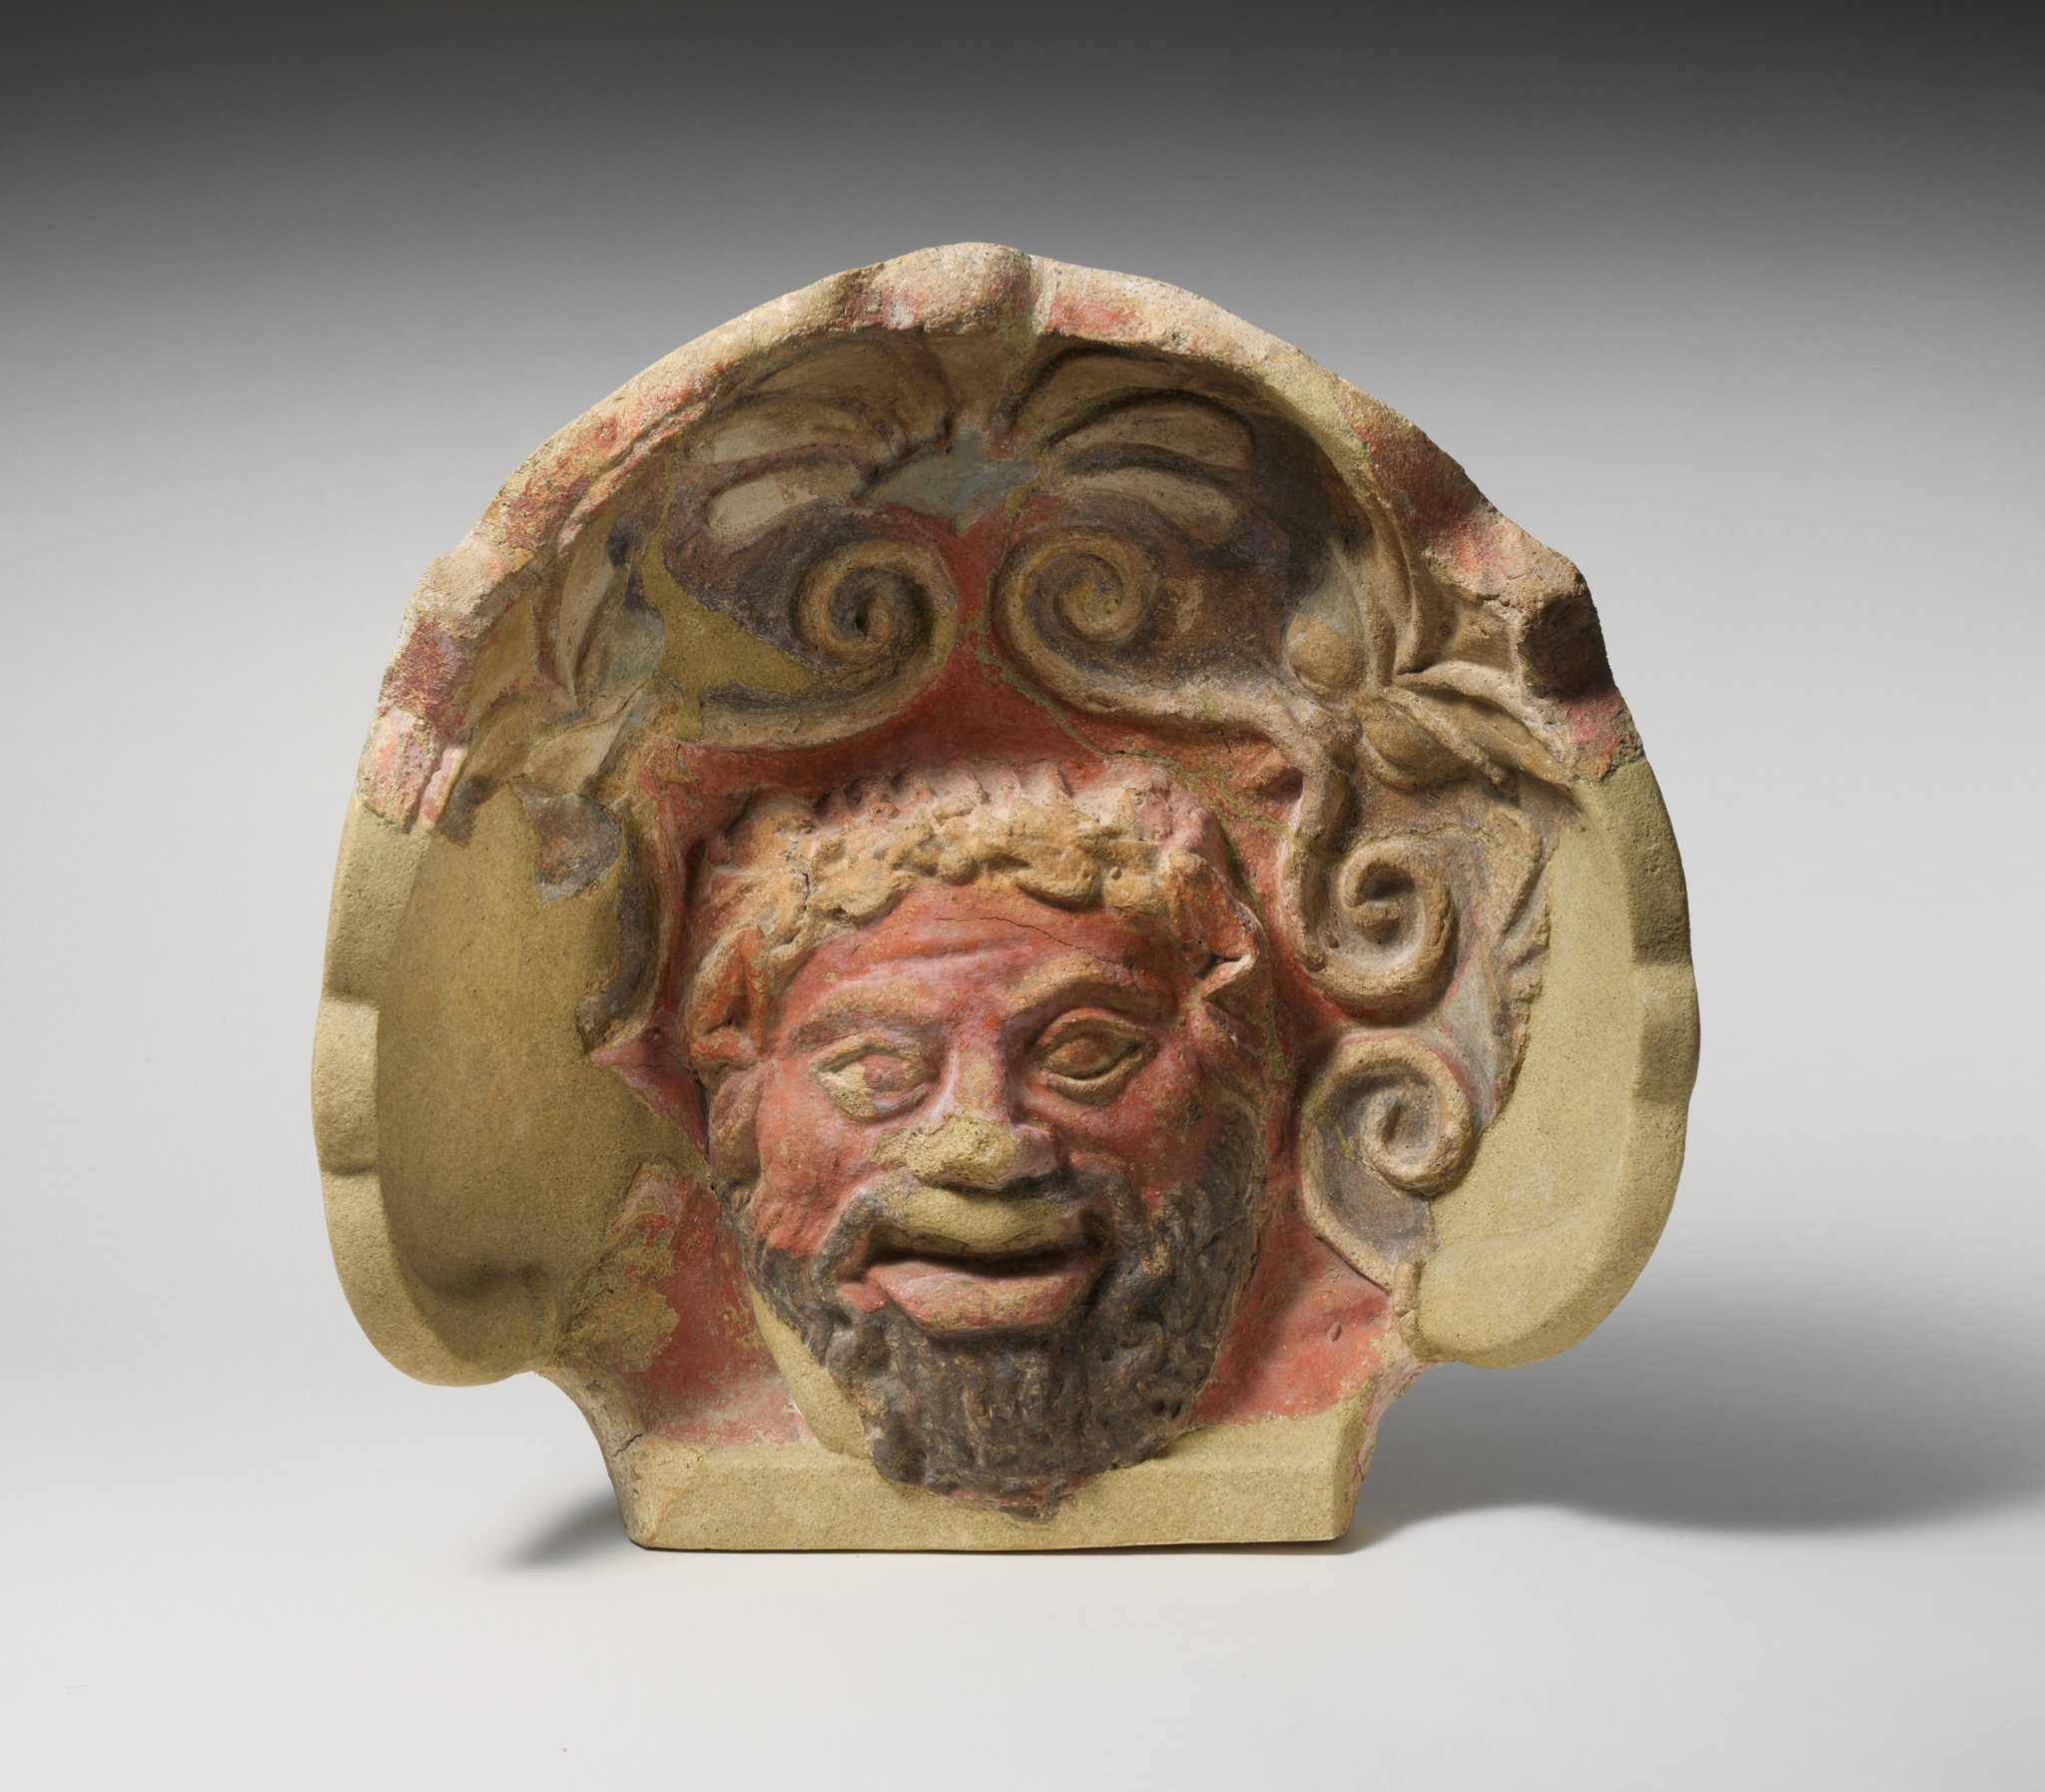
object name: antefix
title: Terracotta antefix (roof tile) with head of a satyr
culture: etruscan, cerveteri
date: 400-301 BCE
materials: terracotta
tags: heads,satyrs